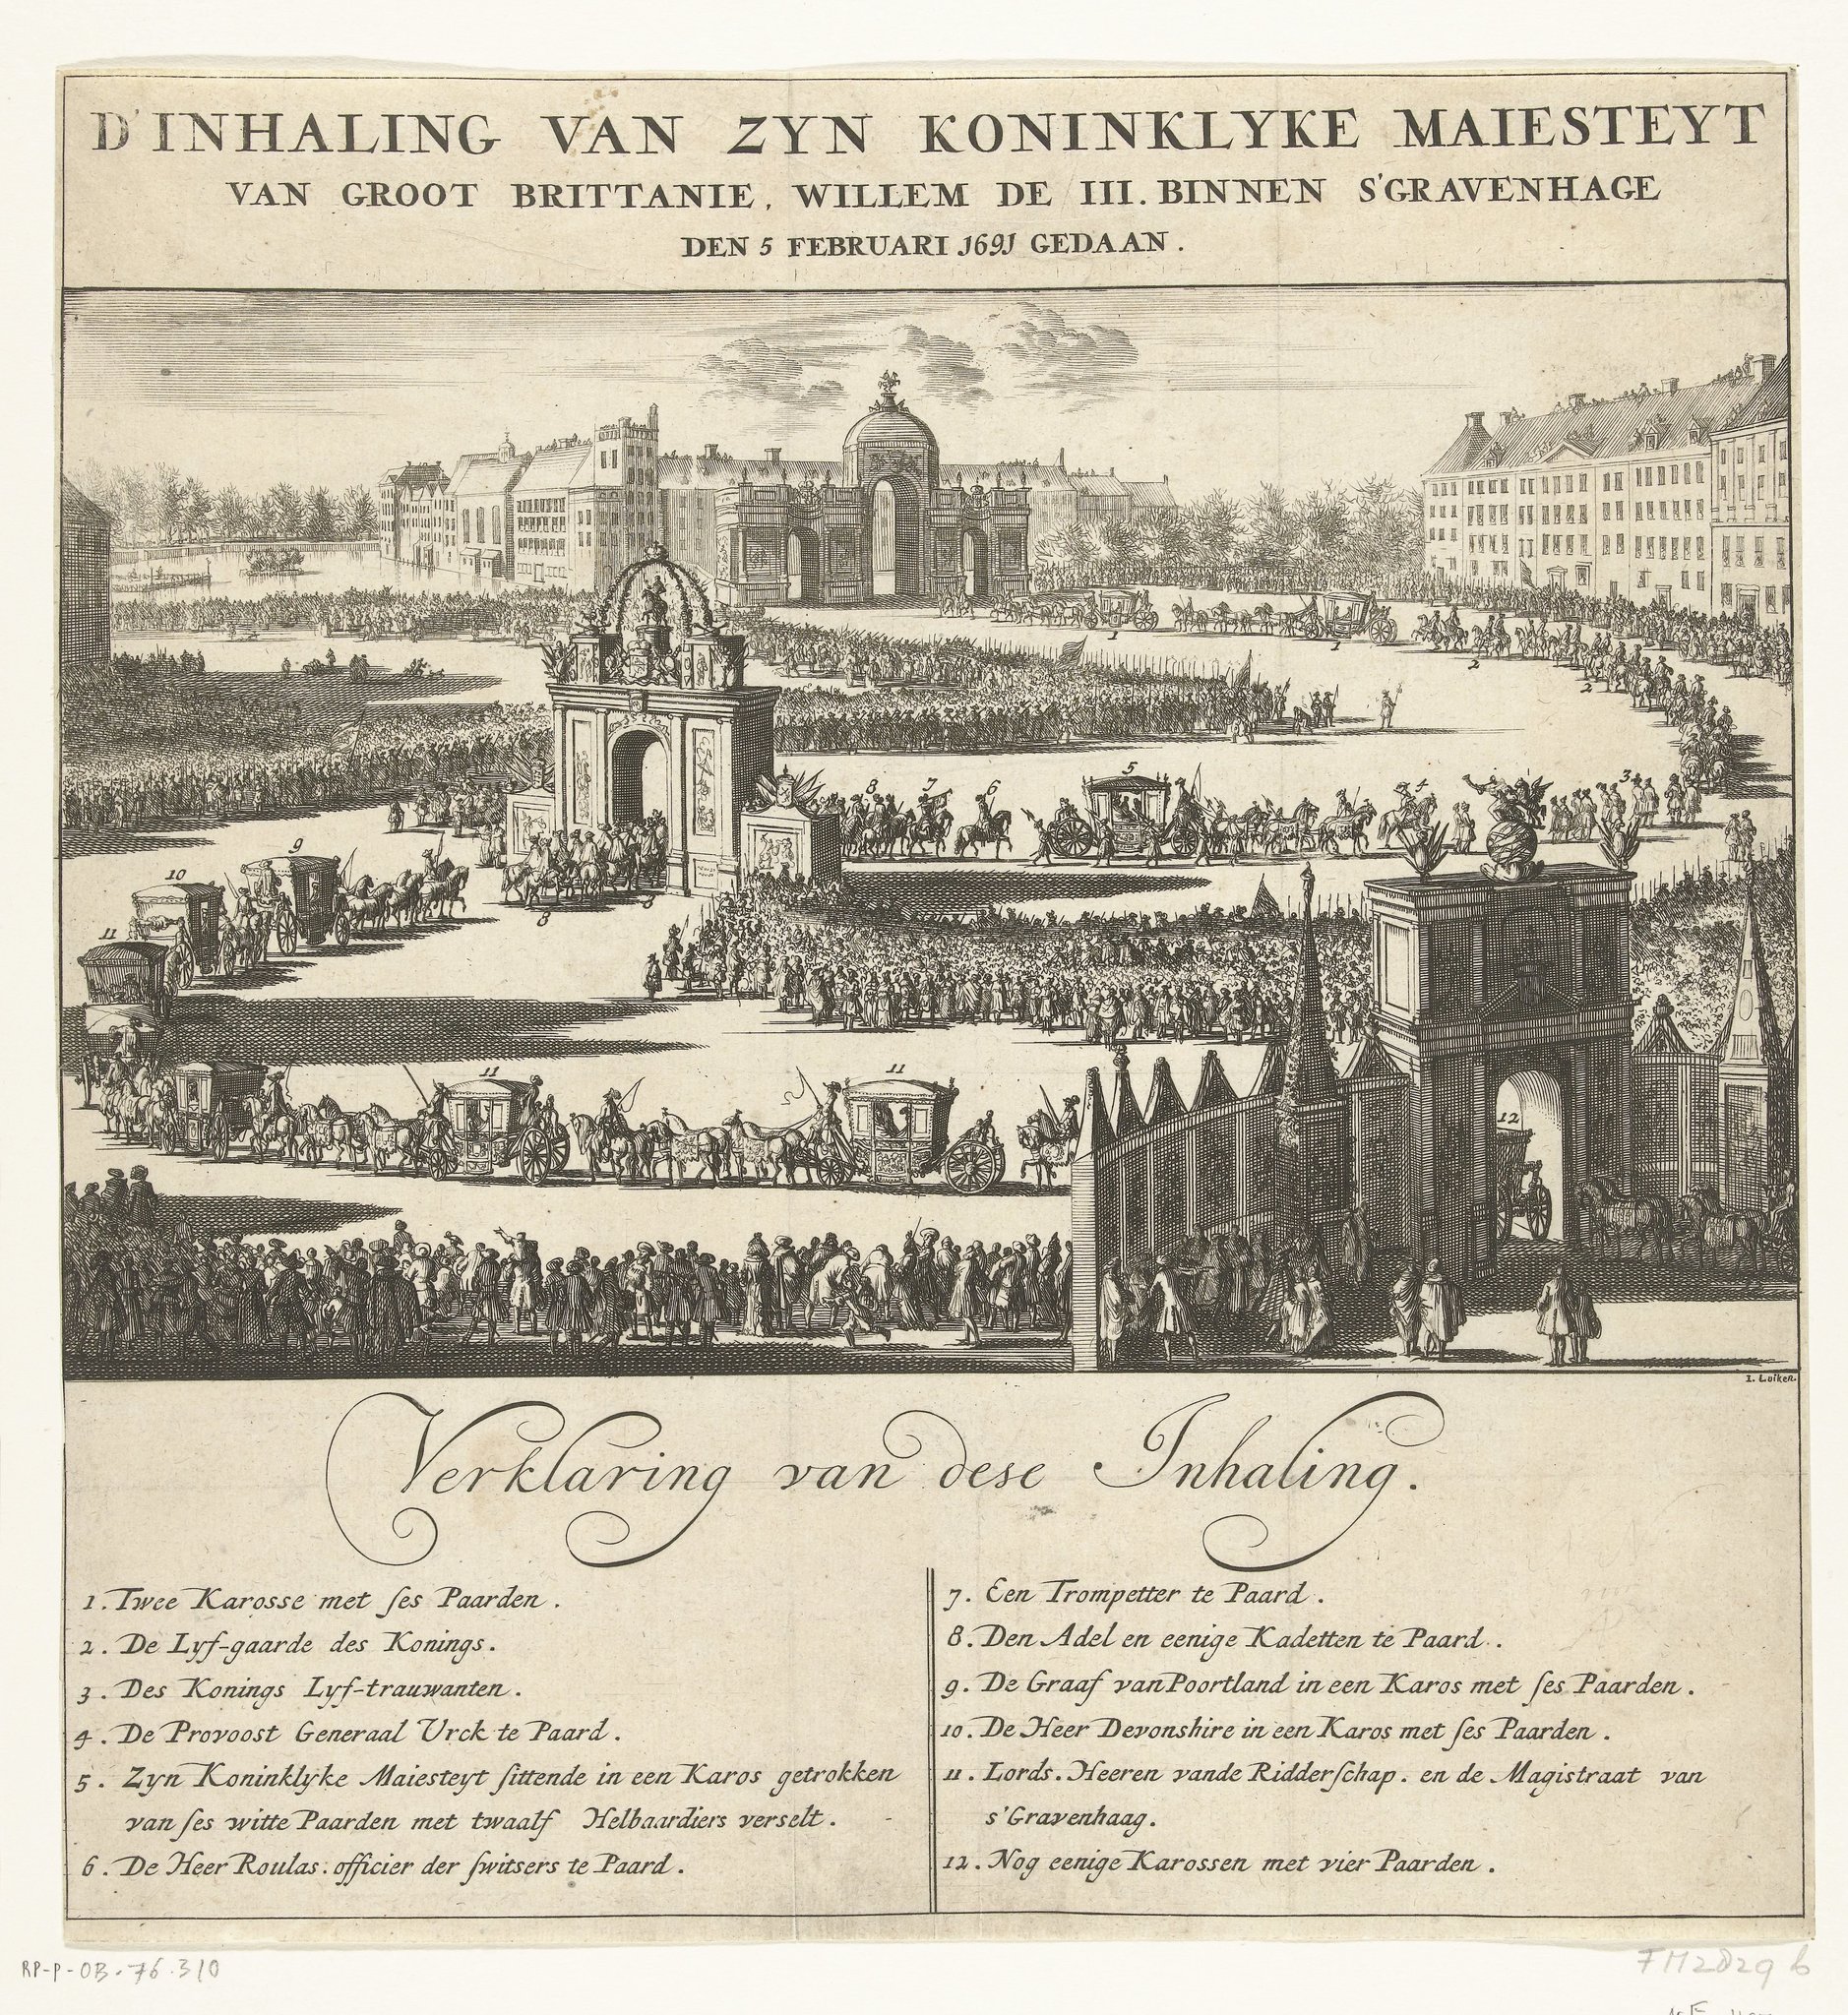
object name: print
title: D'Inhaling van zyn Koninklyke Majesteyt van Groot Brittanie, Willem de III, binnen s'Gravenhage den 5 februari 1691 gedaan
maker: jan luyken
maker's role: draughtsman, print maker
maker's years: 1649-1712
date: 1691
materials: paper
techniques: etching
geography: northern netherlands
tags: the hague, william iii (prince of orange and king of england, scotland, and ireland), triumphal arch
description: De intrede van de stoet met koning Willem III door de triomfbogen opgesteld bij het Buitenhof naar het Stadhouderlijk Kwartier, 5 februari 1691. Onder de plaat de legenda 1-12. Zonder het paginanummer.